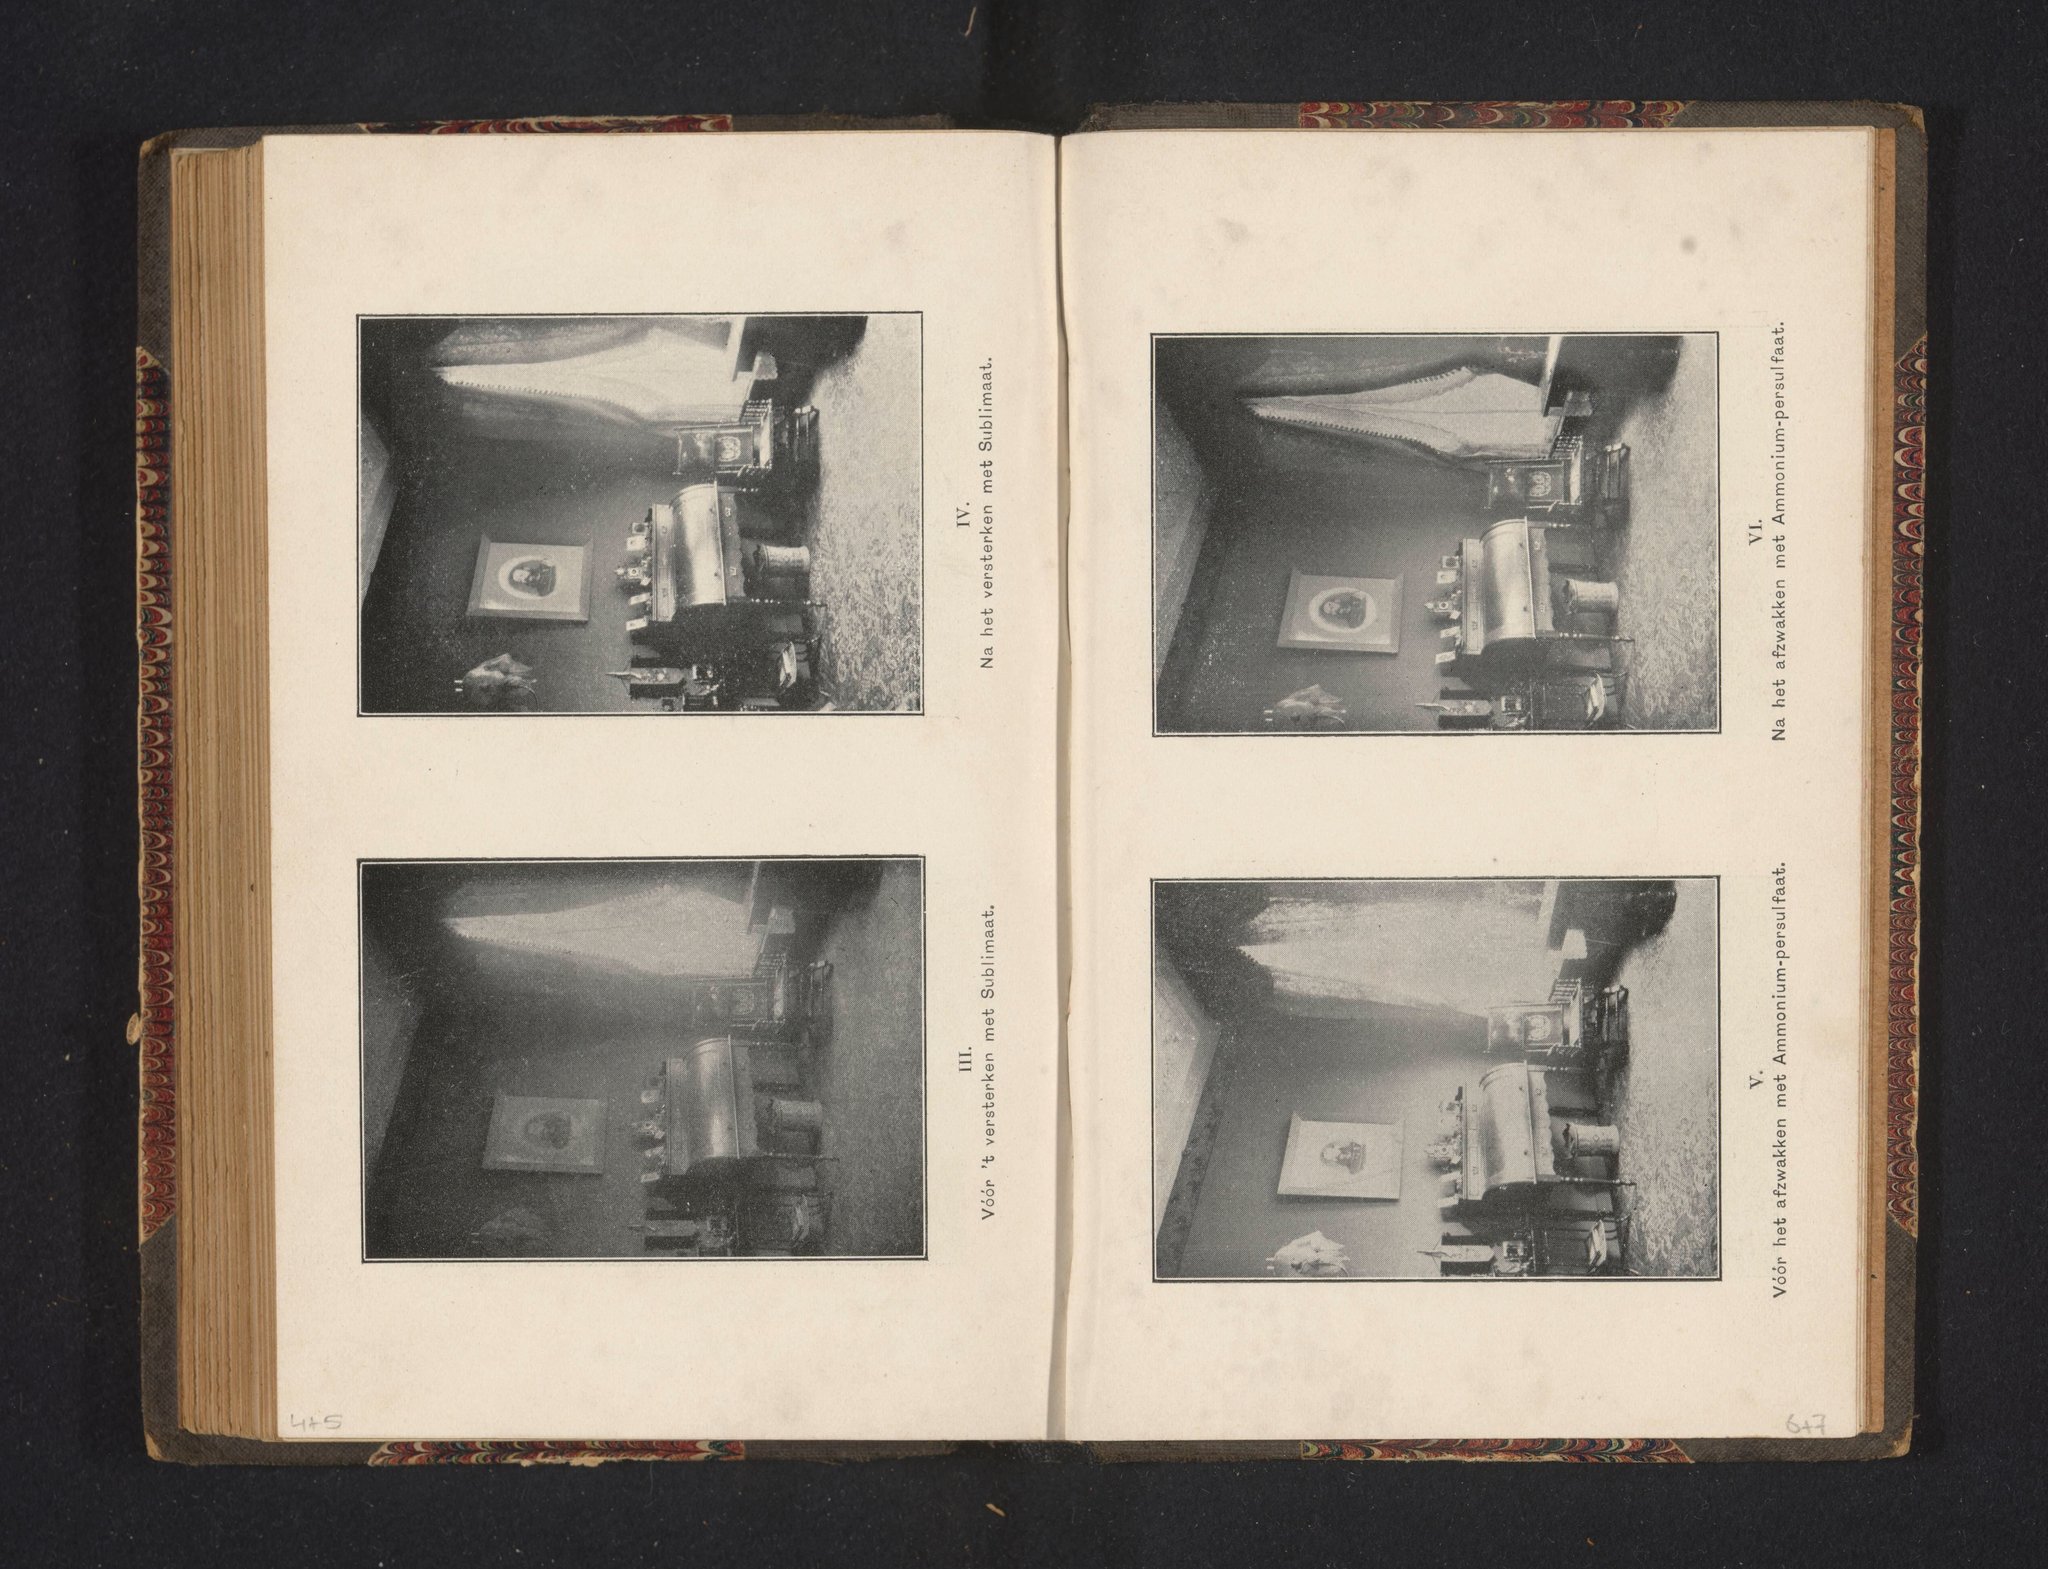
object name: photomechanical print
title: IV./ Na het versterken met Sublimaat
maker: Anonymous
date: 1897-1902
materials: paper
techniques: autotype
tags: writing-table, writing-desk, interior of the house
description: Prent vier van veertien prenten na pagina 241.